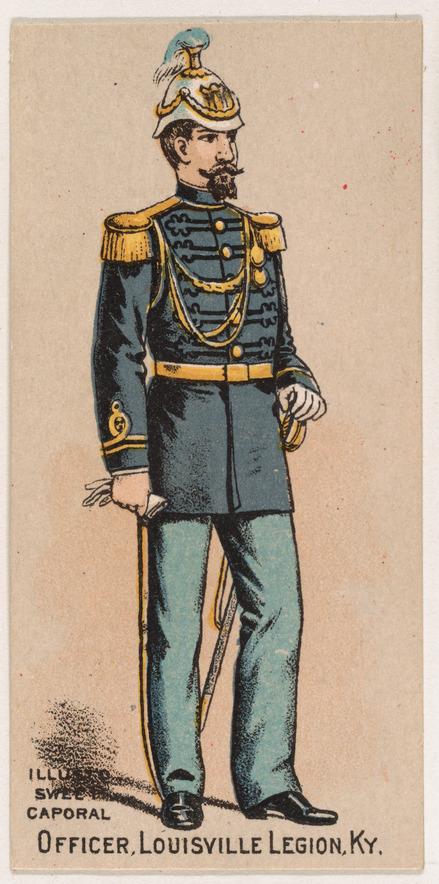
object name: print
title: Officer, Louisville Legion, Kentucky, from the Military Series (N224) issued by Kinney Tobacco Company to promote Sweet Caporal Cigarettes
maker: kinney brothers tobacco company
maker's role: publisher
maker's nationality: american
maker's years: 1869-2011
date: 1888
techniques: color lithograph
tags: military,men